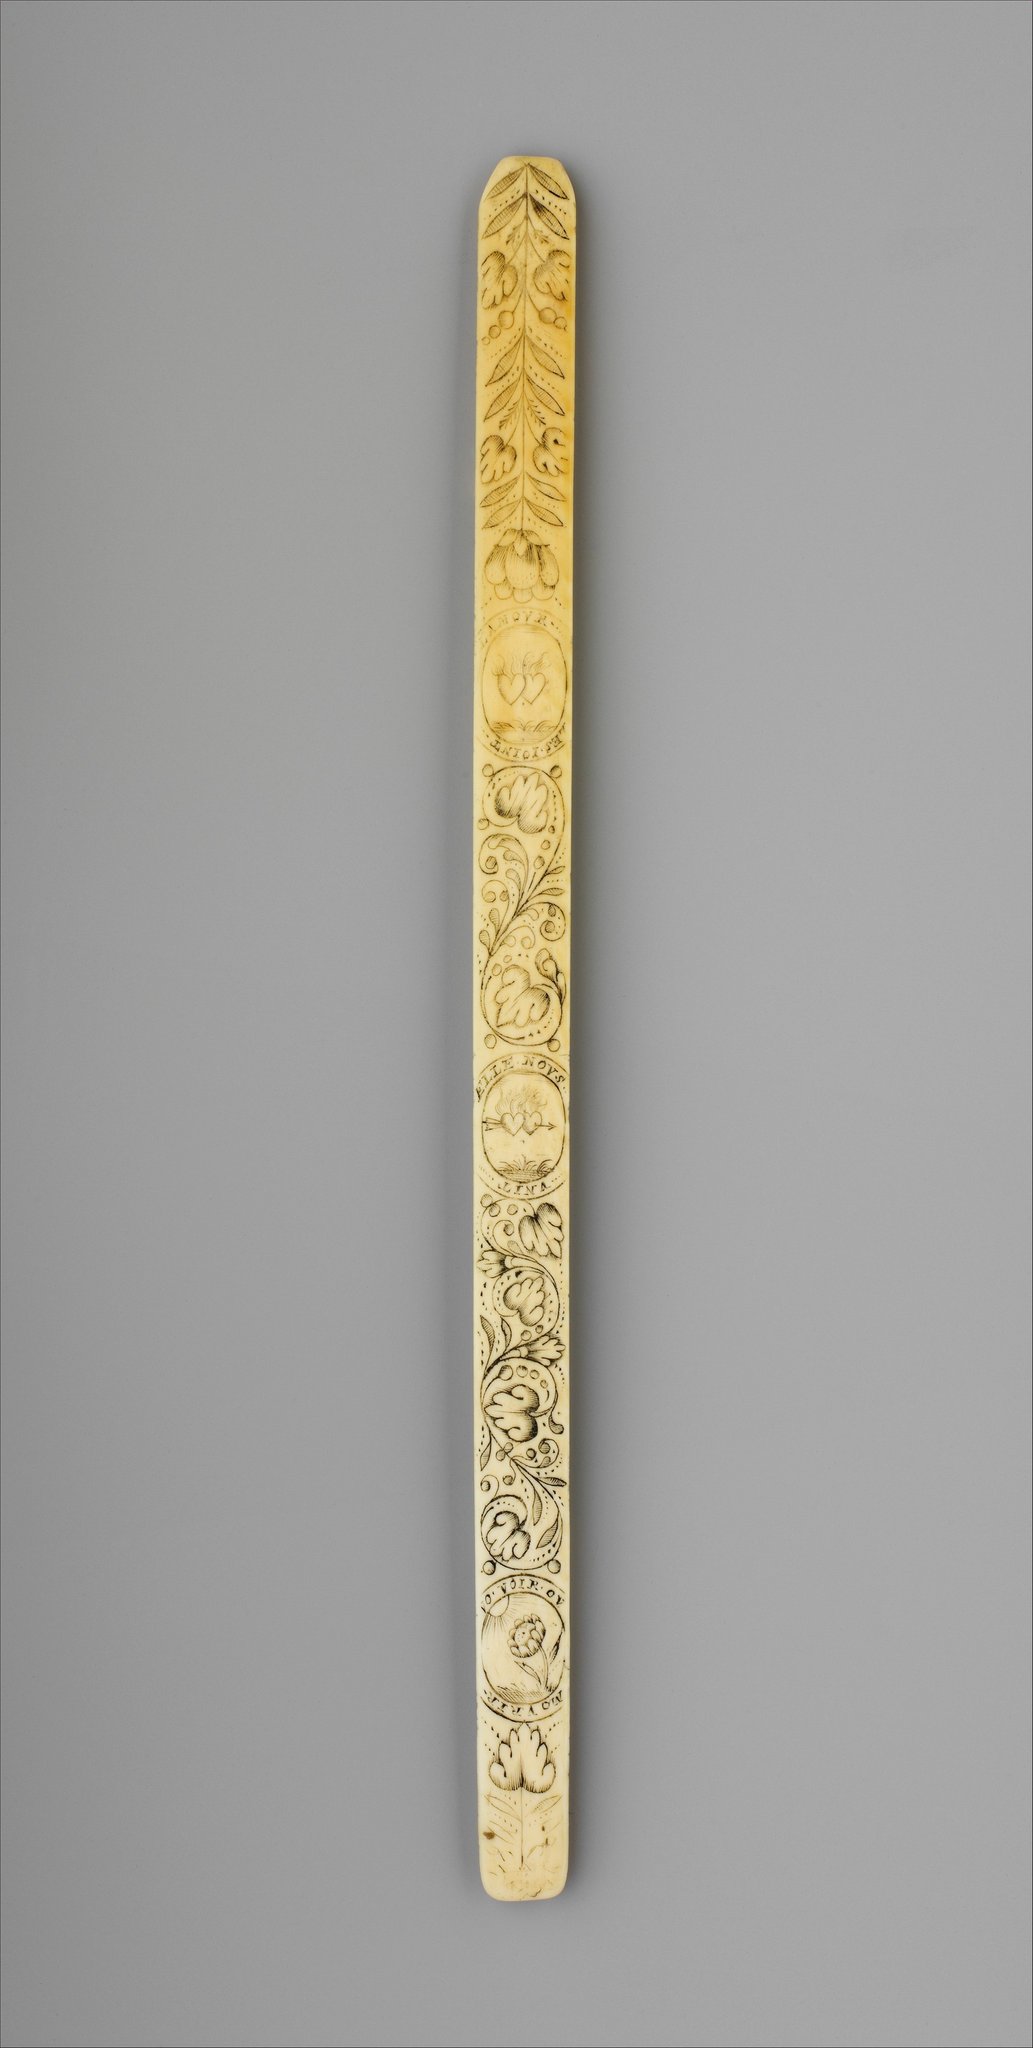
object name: busk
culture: french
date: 1601-1700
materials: ivory